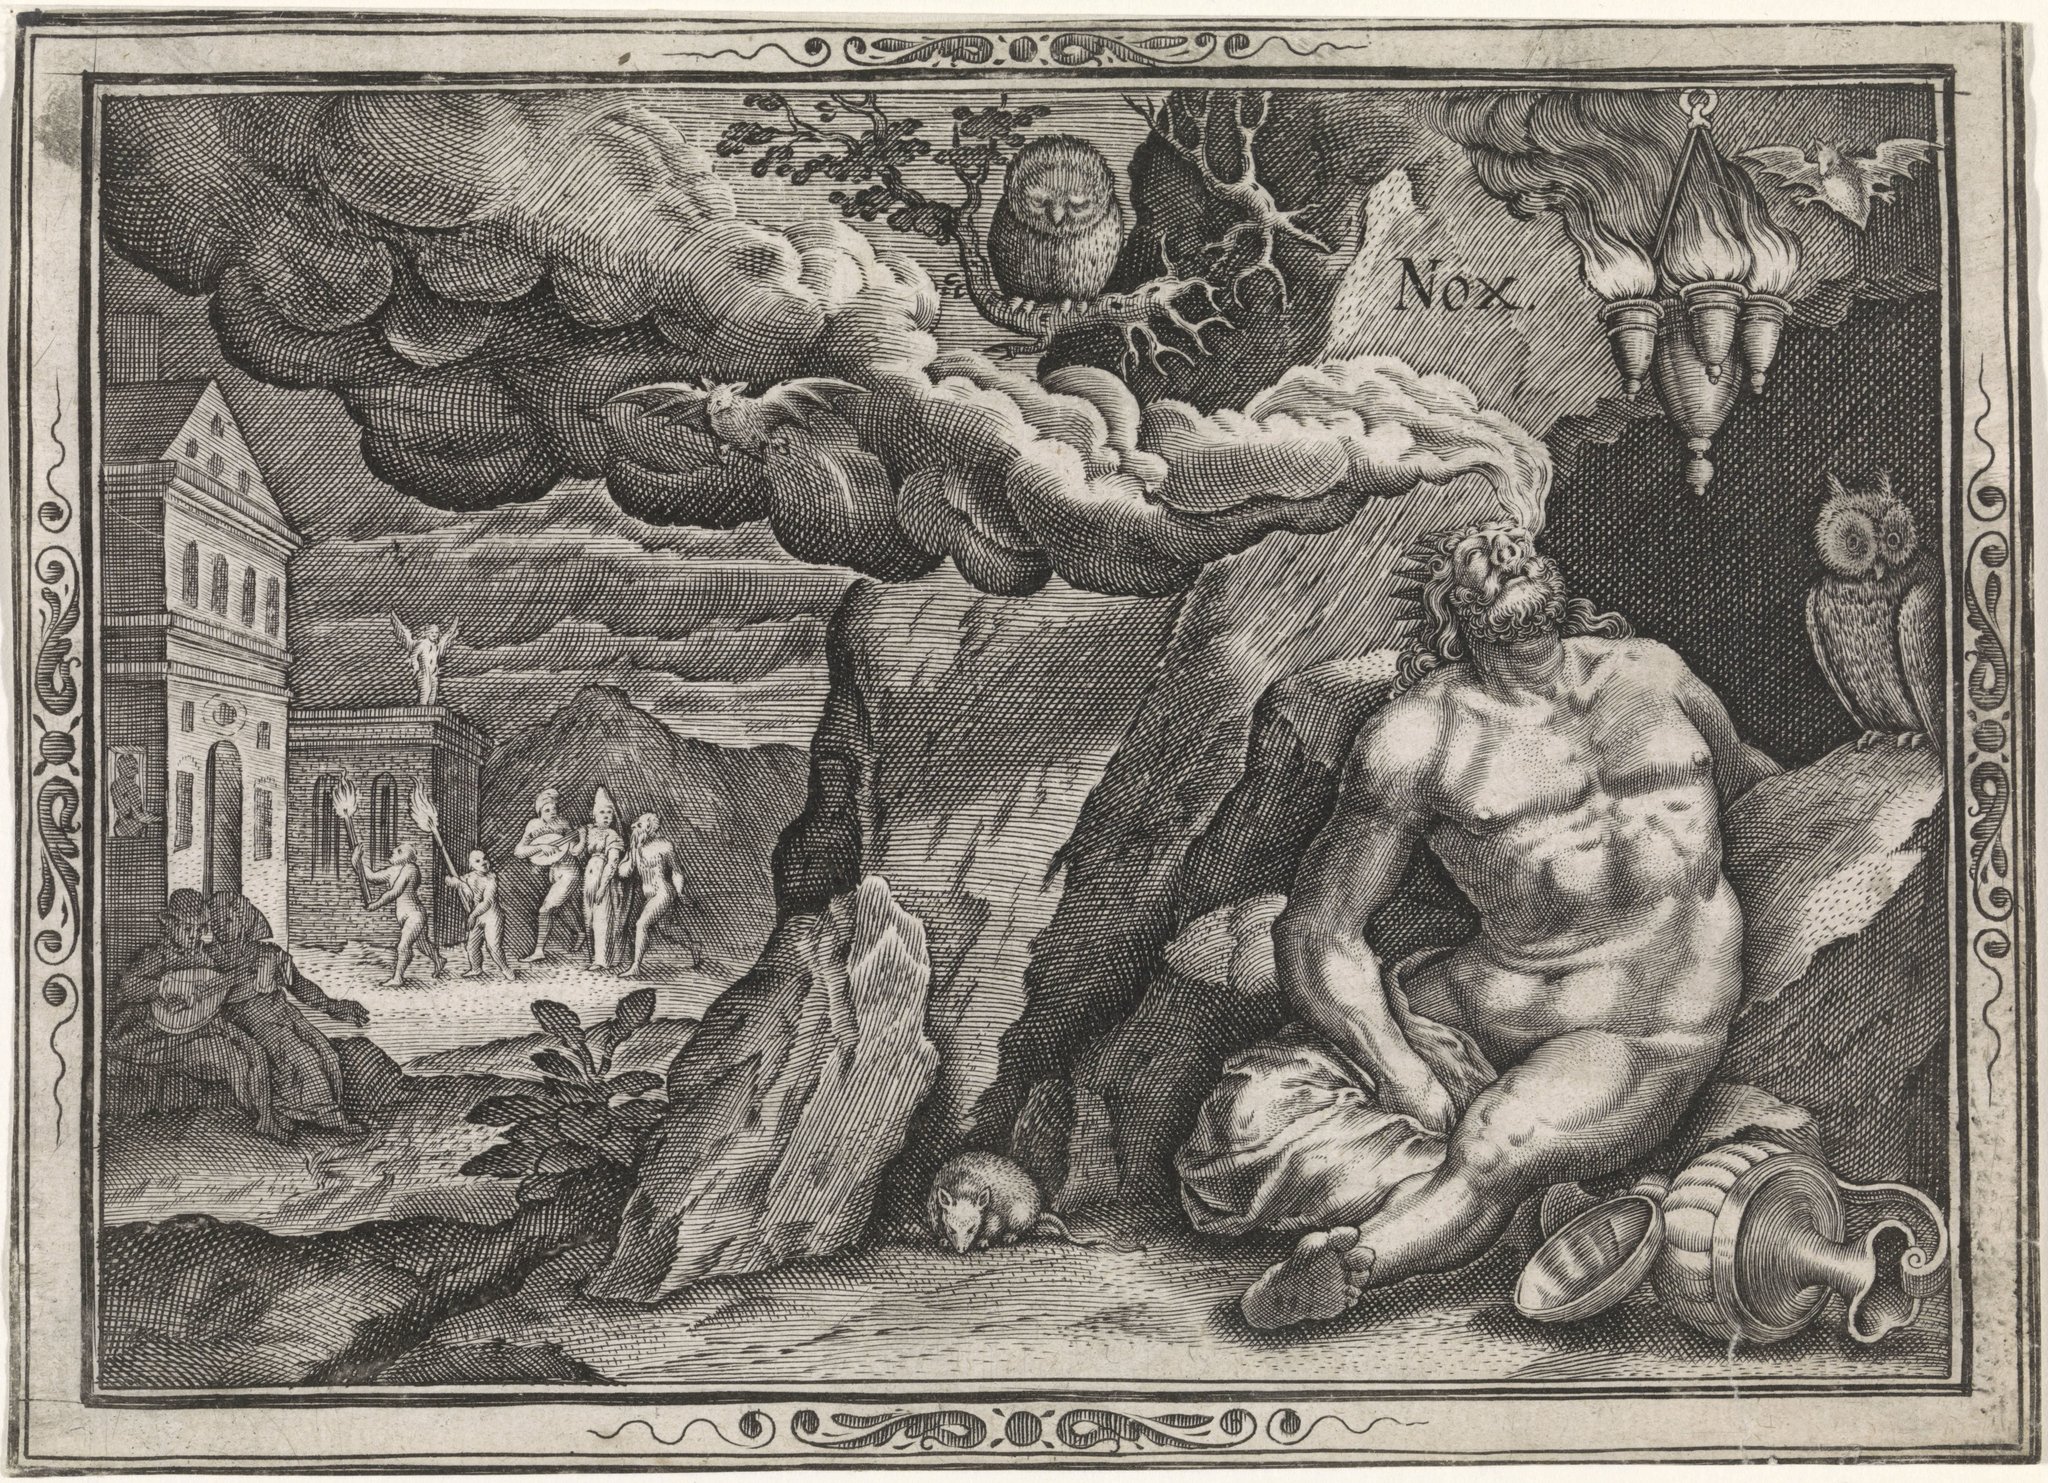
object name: print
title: Nacht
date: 1667-1736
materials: paper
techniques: engraving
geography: cologne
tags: flying mammals: bat, personification of the night, 'nox'; 'notte', 'carro della notte', 'serenità della notte' (ripa), night ~ landscape (sometimes titled 'nox'), owls, couple of lovers, night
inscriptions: collector's mark: Lugt 2228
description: De slapende Nox, de personificatie van de nacht. Uit zijn mond ontsnapt een wolk van duisternis. Naast hem een uil, een vleermuis en een rat. Links een verliefd paar. Op de achtergrond brengt een gemaskerde man een gesluierde vrouw naar een tempel.